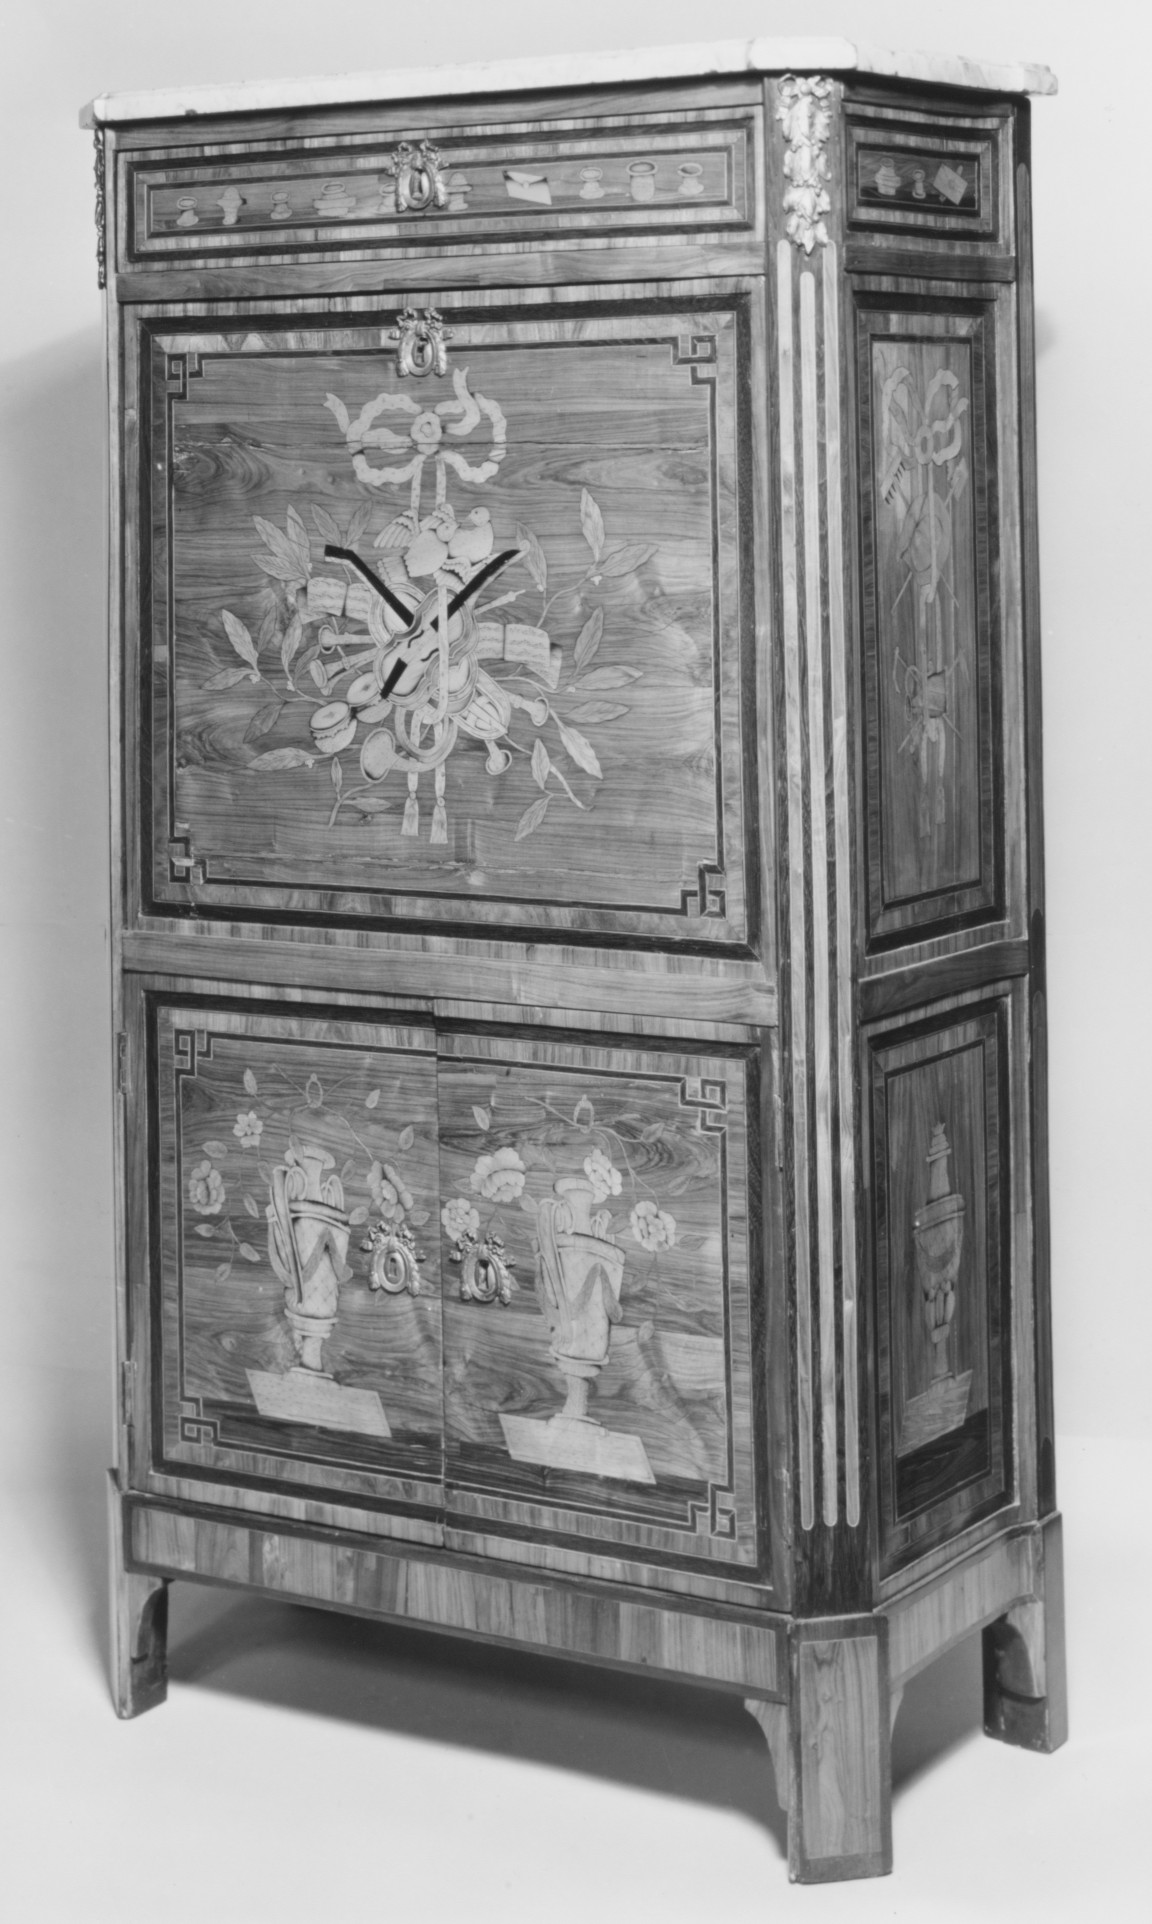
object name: secretary desk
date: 1776-1800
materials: gilt bronze, marble, wood